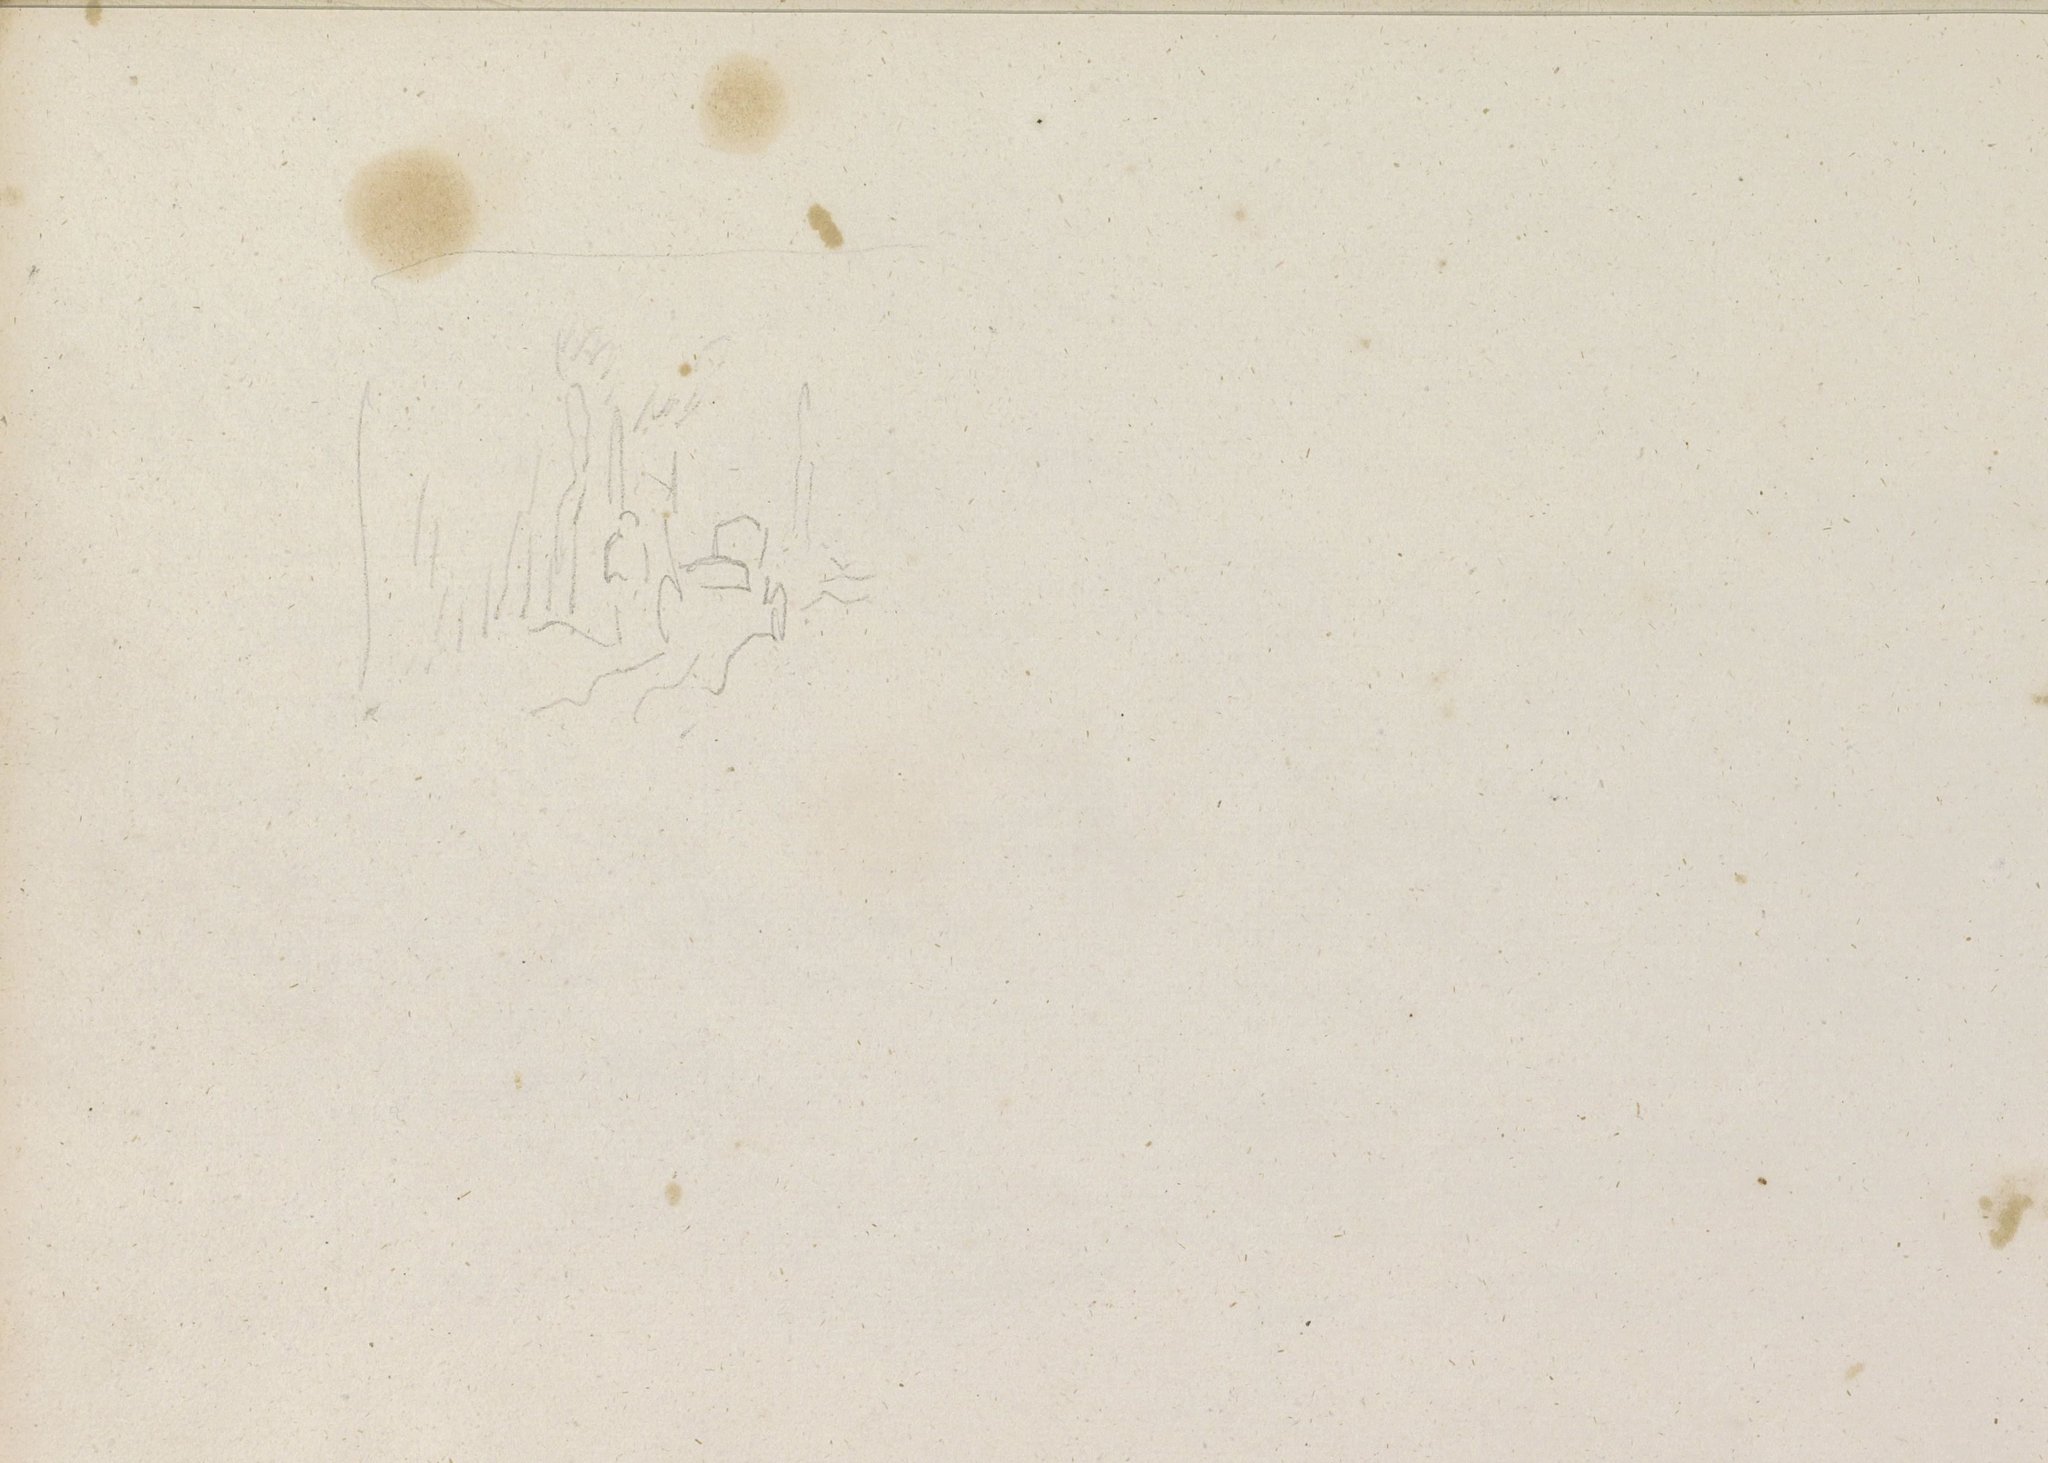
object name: sketchbook leaf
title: Studie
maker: anton mauve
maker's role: draughtsman, painter, print maker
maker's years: 1838-1888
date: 1848-1888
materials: paper, pencil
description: Blad 19 verso uit een schetsboek met 34 bladen.